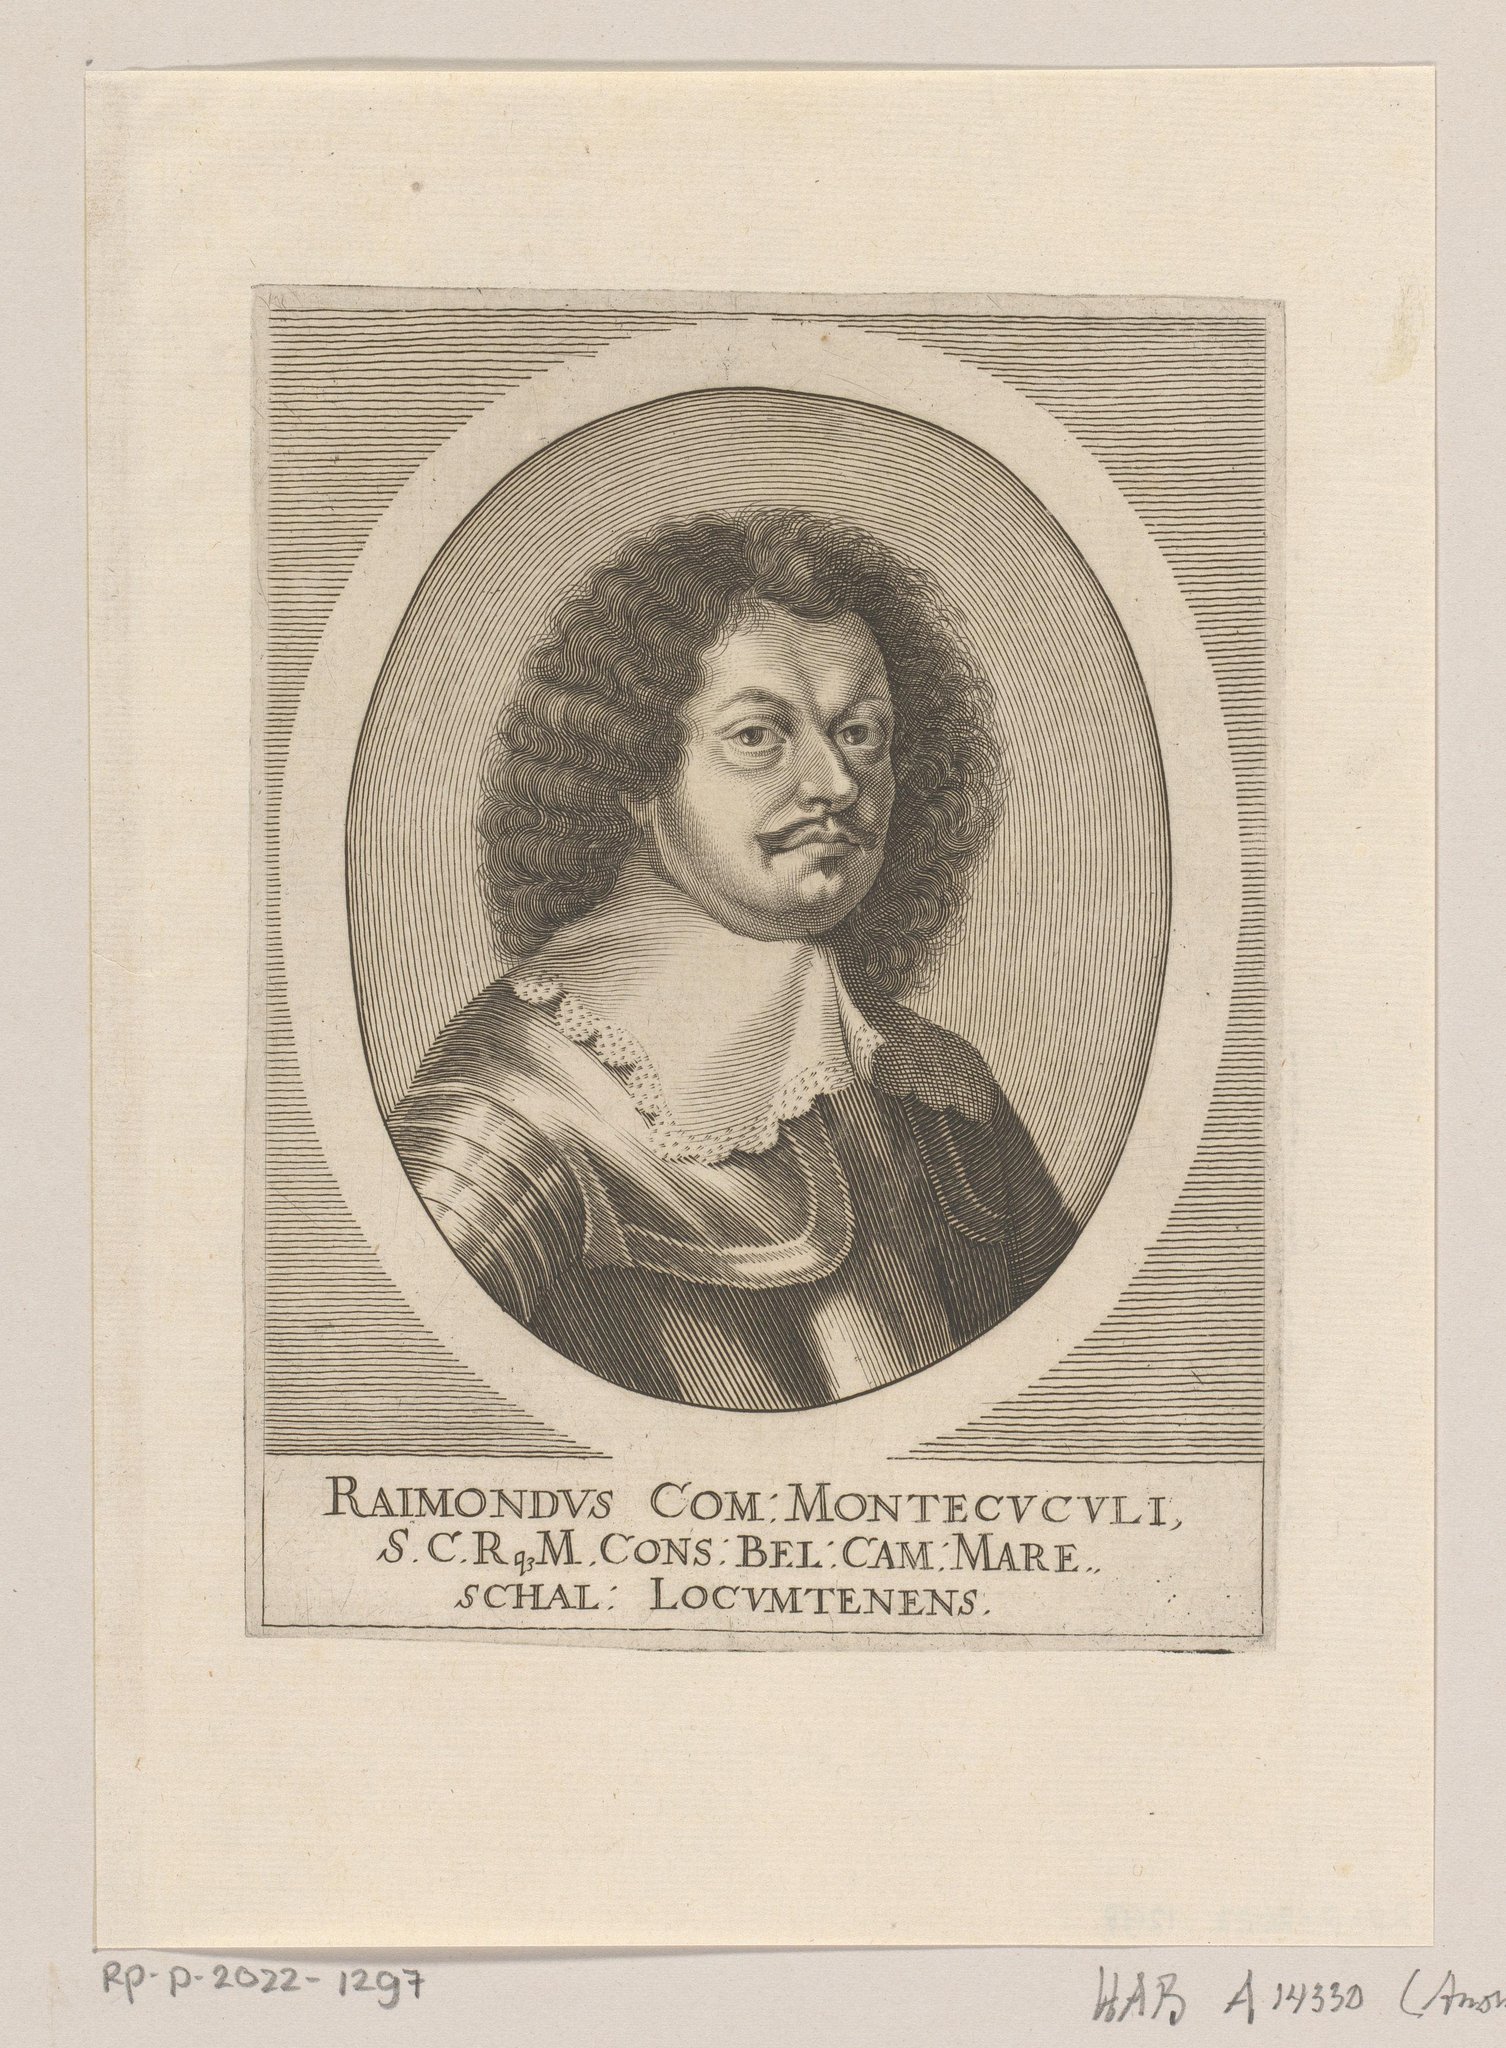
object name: print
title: Raimondus Com: Montecuculi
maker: Anonymous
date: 1682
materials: paper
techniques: engraving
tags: commander-in-chief, general, marshal, historical persons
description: Prent waarschijnlijk uit: Theatrum Europaeum. Frankfurt am Main: erven Matthäus Merian, 1682, dl. 11.